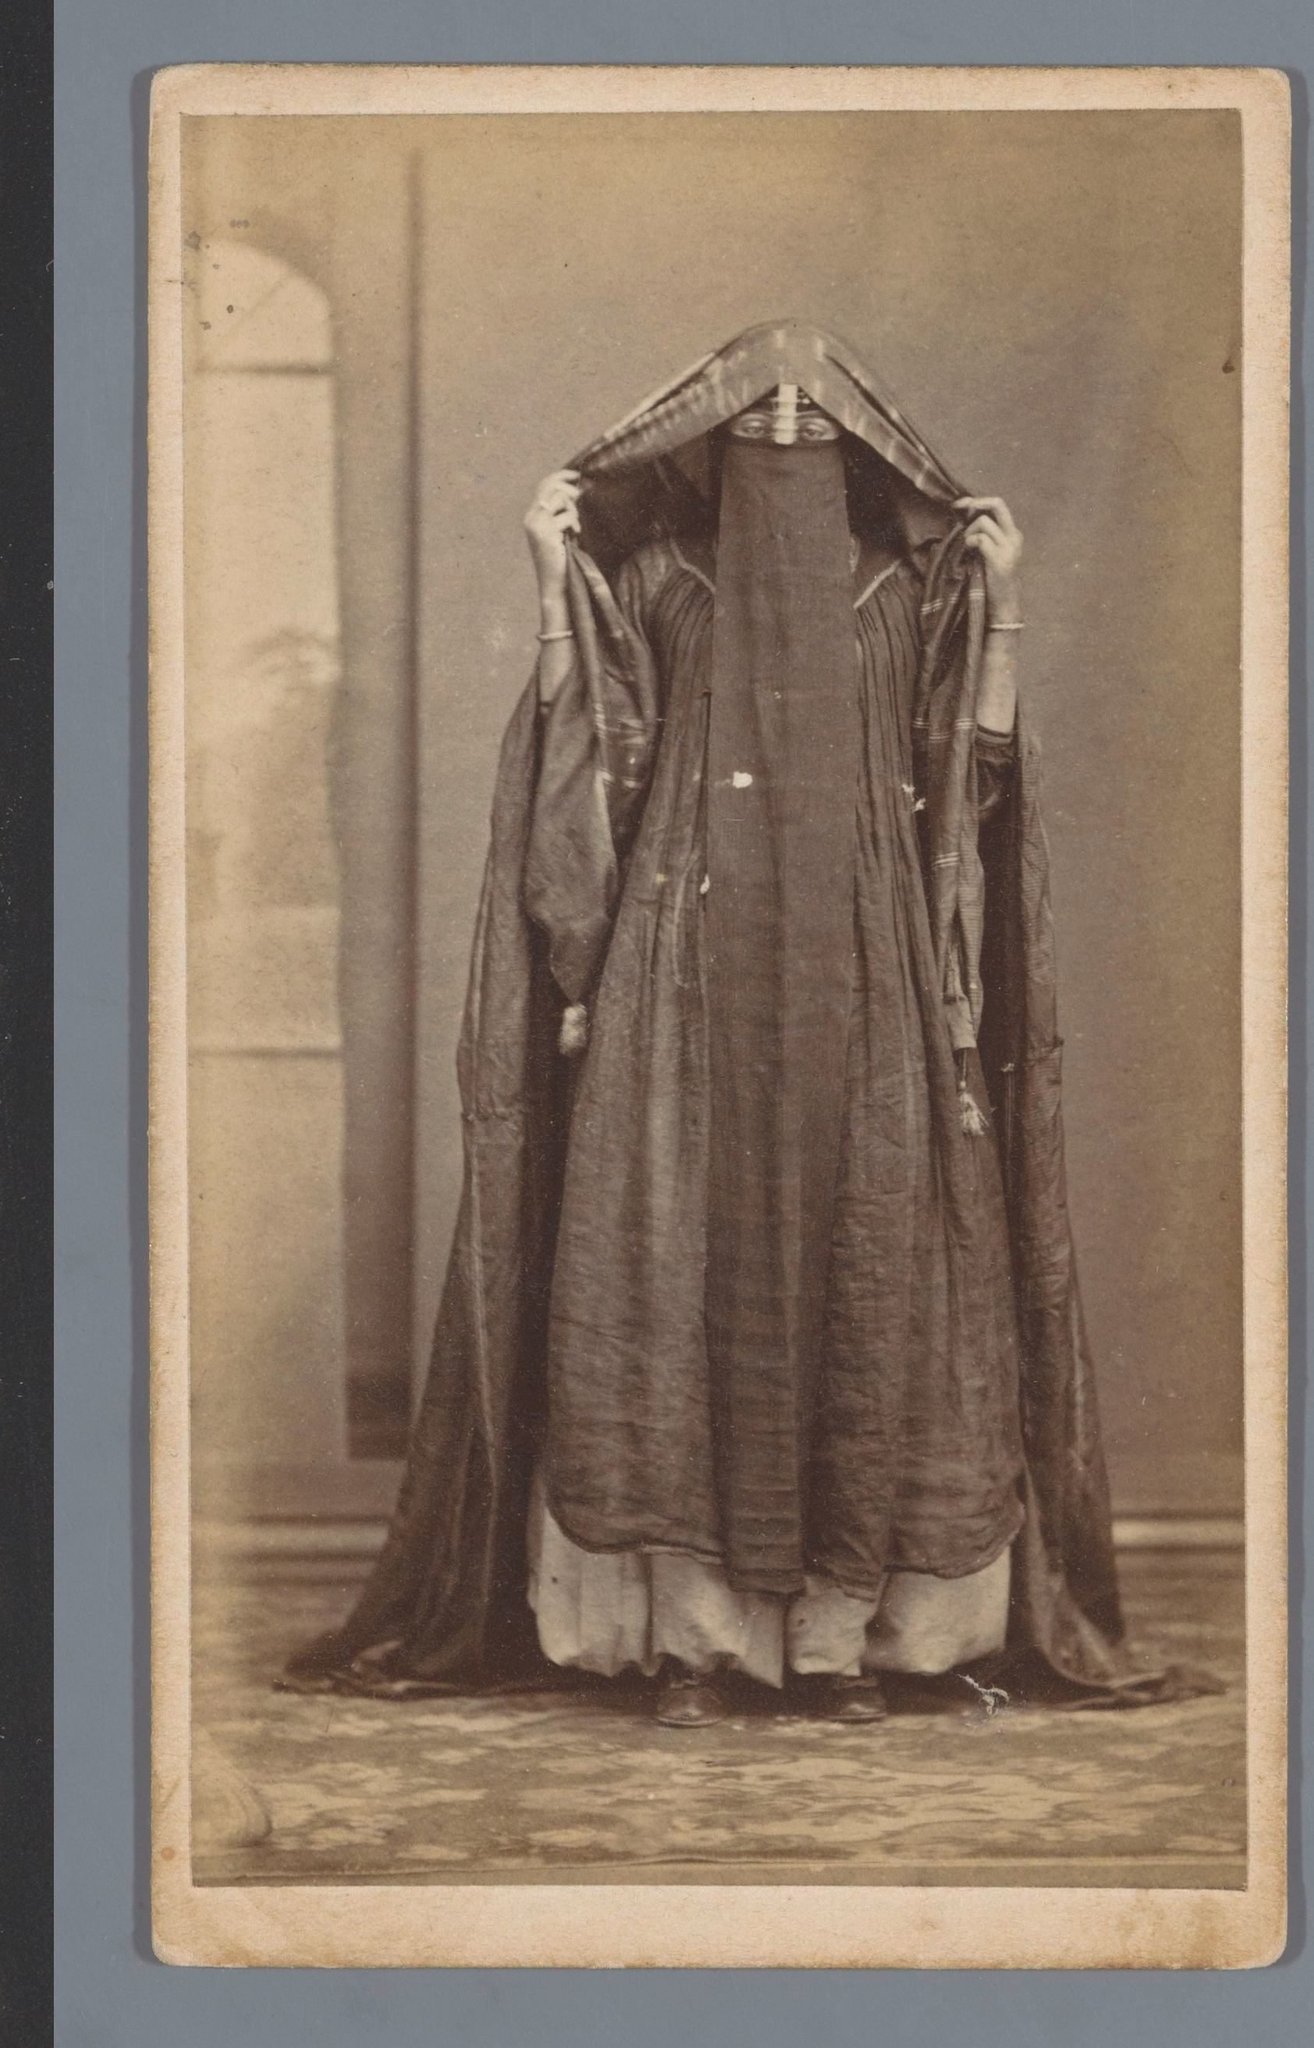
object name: carte de visite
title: Portret van een gesluierde Arabische vrouw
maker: Anonymous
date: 1870-1900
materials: cardboard, paper, photographic support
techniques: albumen print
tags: historical persons not known by name - bb - woman